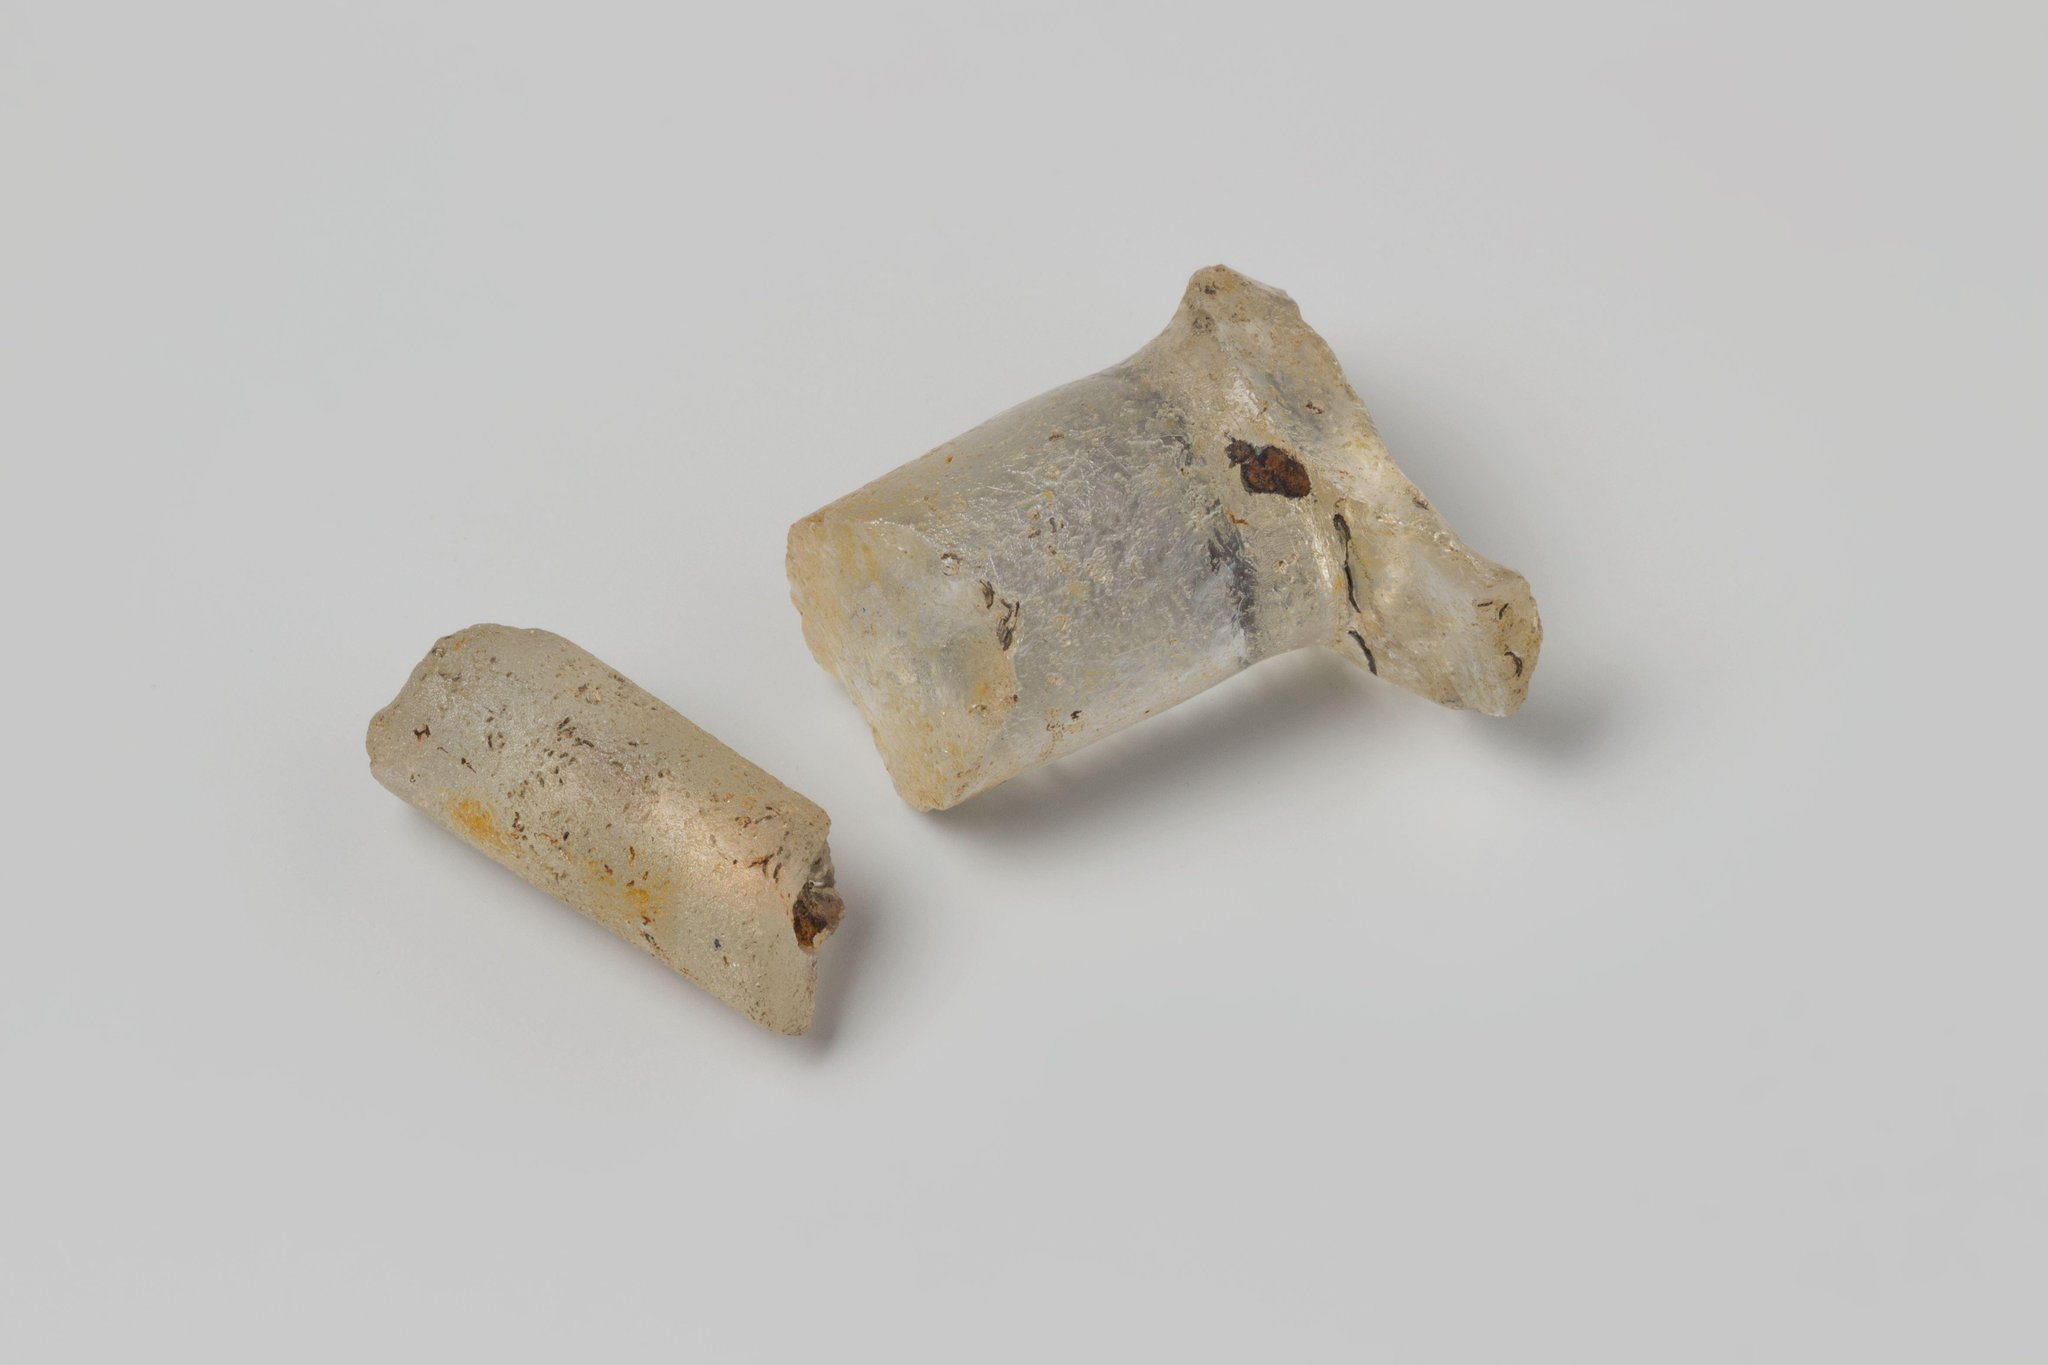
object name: flute glass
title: Fragmenten rechte steel van glas uit het wrak van de Oost-Indiëvaarder Hollandia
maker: Anonymous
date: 1700-1743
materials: glass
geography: netherlands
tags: verenigde oostindische compagnie, hollandia (schip), annet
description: Glass, stem glass, stems, plain; fragm of lower end, circular, solid.